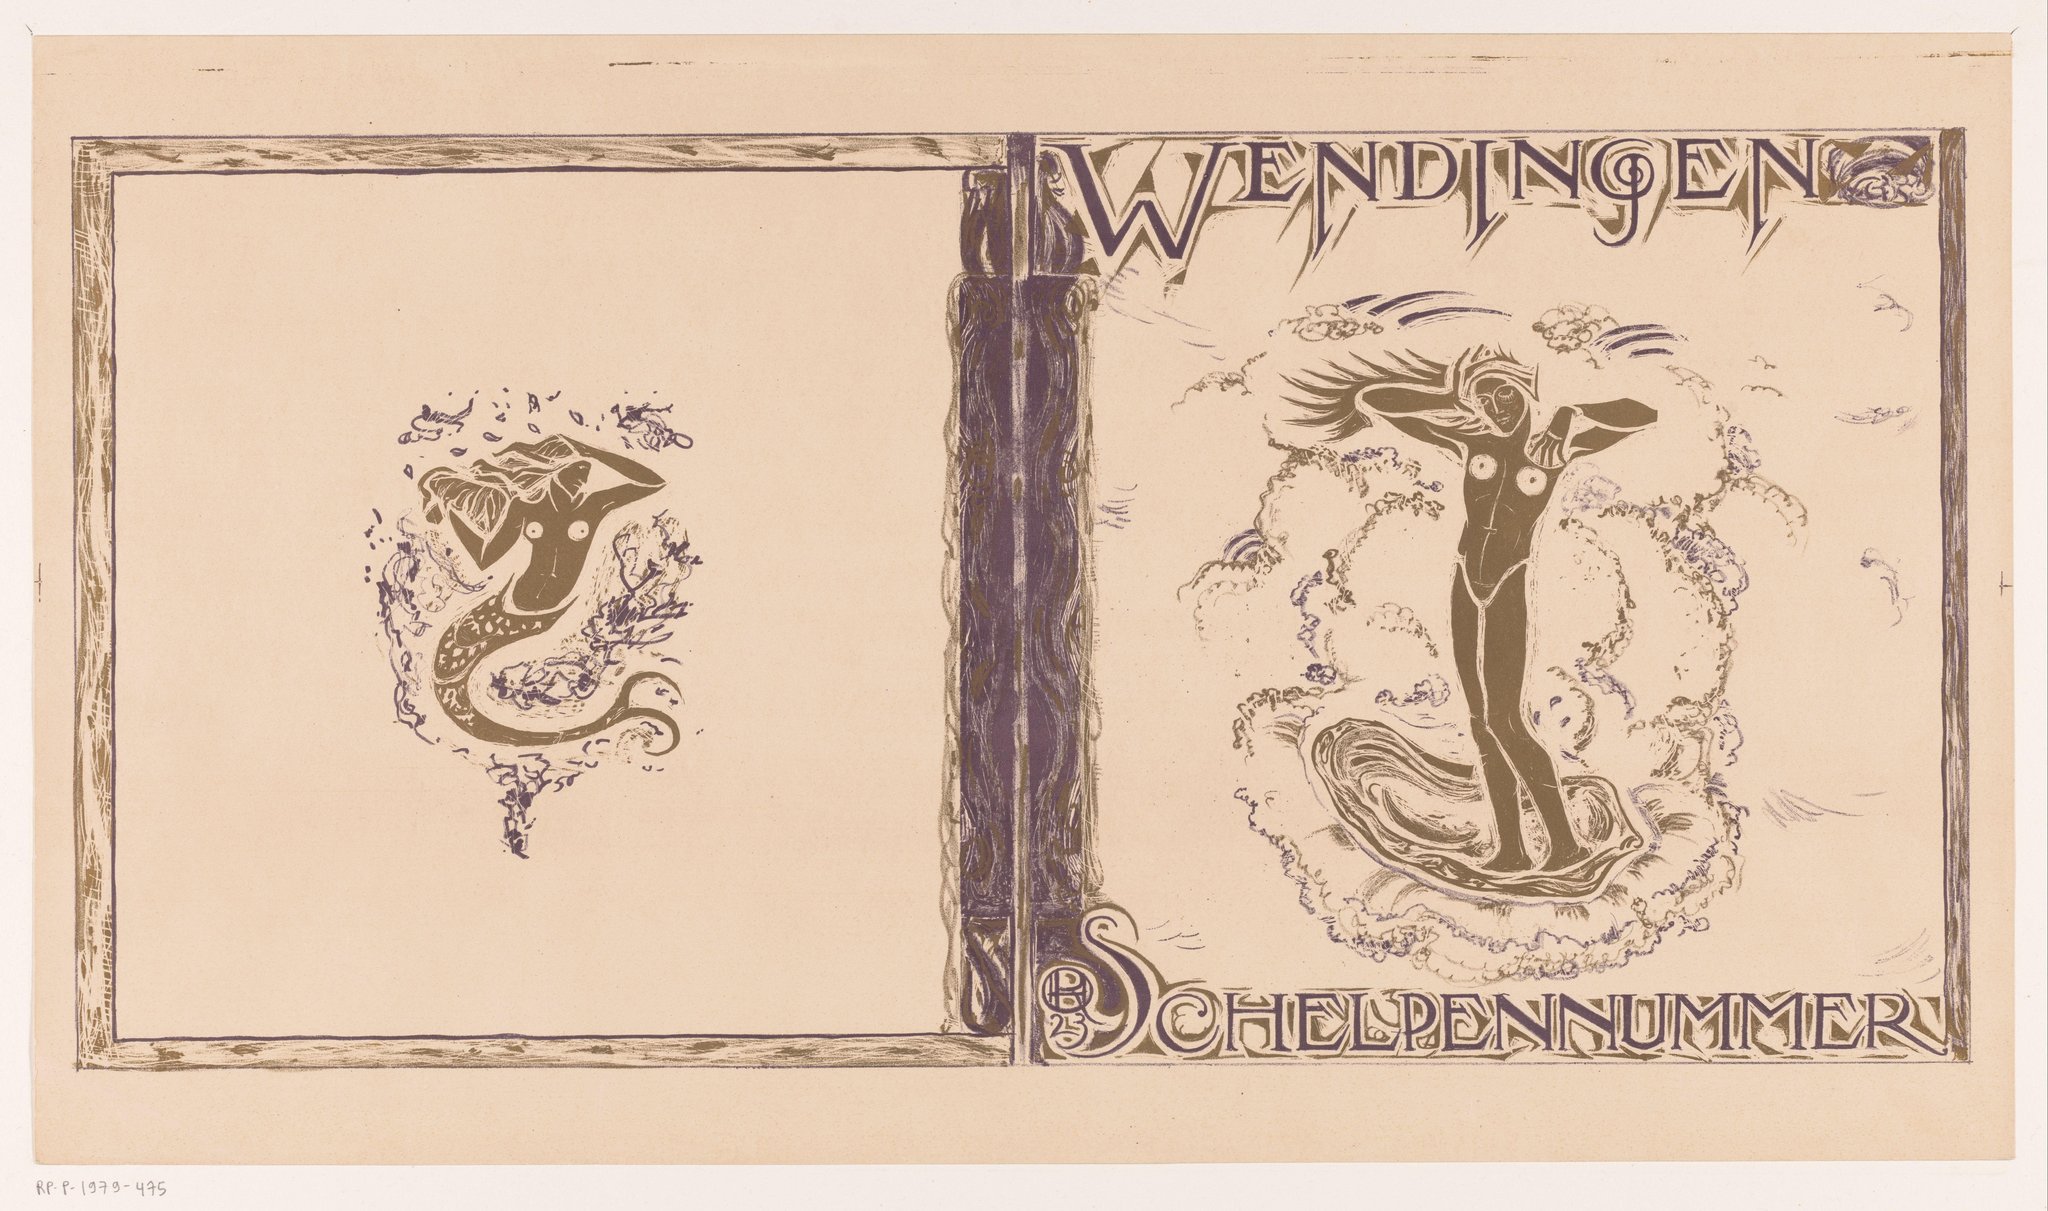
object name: design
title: Omslagontwerp voor: Wendingen, Schelpennummer, 1923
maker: richard nicolaüs roland holst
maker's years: 1868-1938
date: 1923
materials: paper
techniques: lithograph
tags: merman - aa - mermaid, siren, woman (showing herself) undressed, quasi-nude, venus, standing on a shell, sails with her veil over the water (alternatively she is riding on a dolphin): venus marina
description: Links een zeemeermin. Rechts de geboorte van Venus. Ze staat naakt op een schelp die op schuimend water drijft.